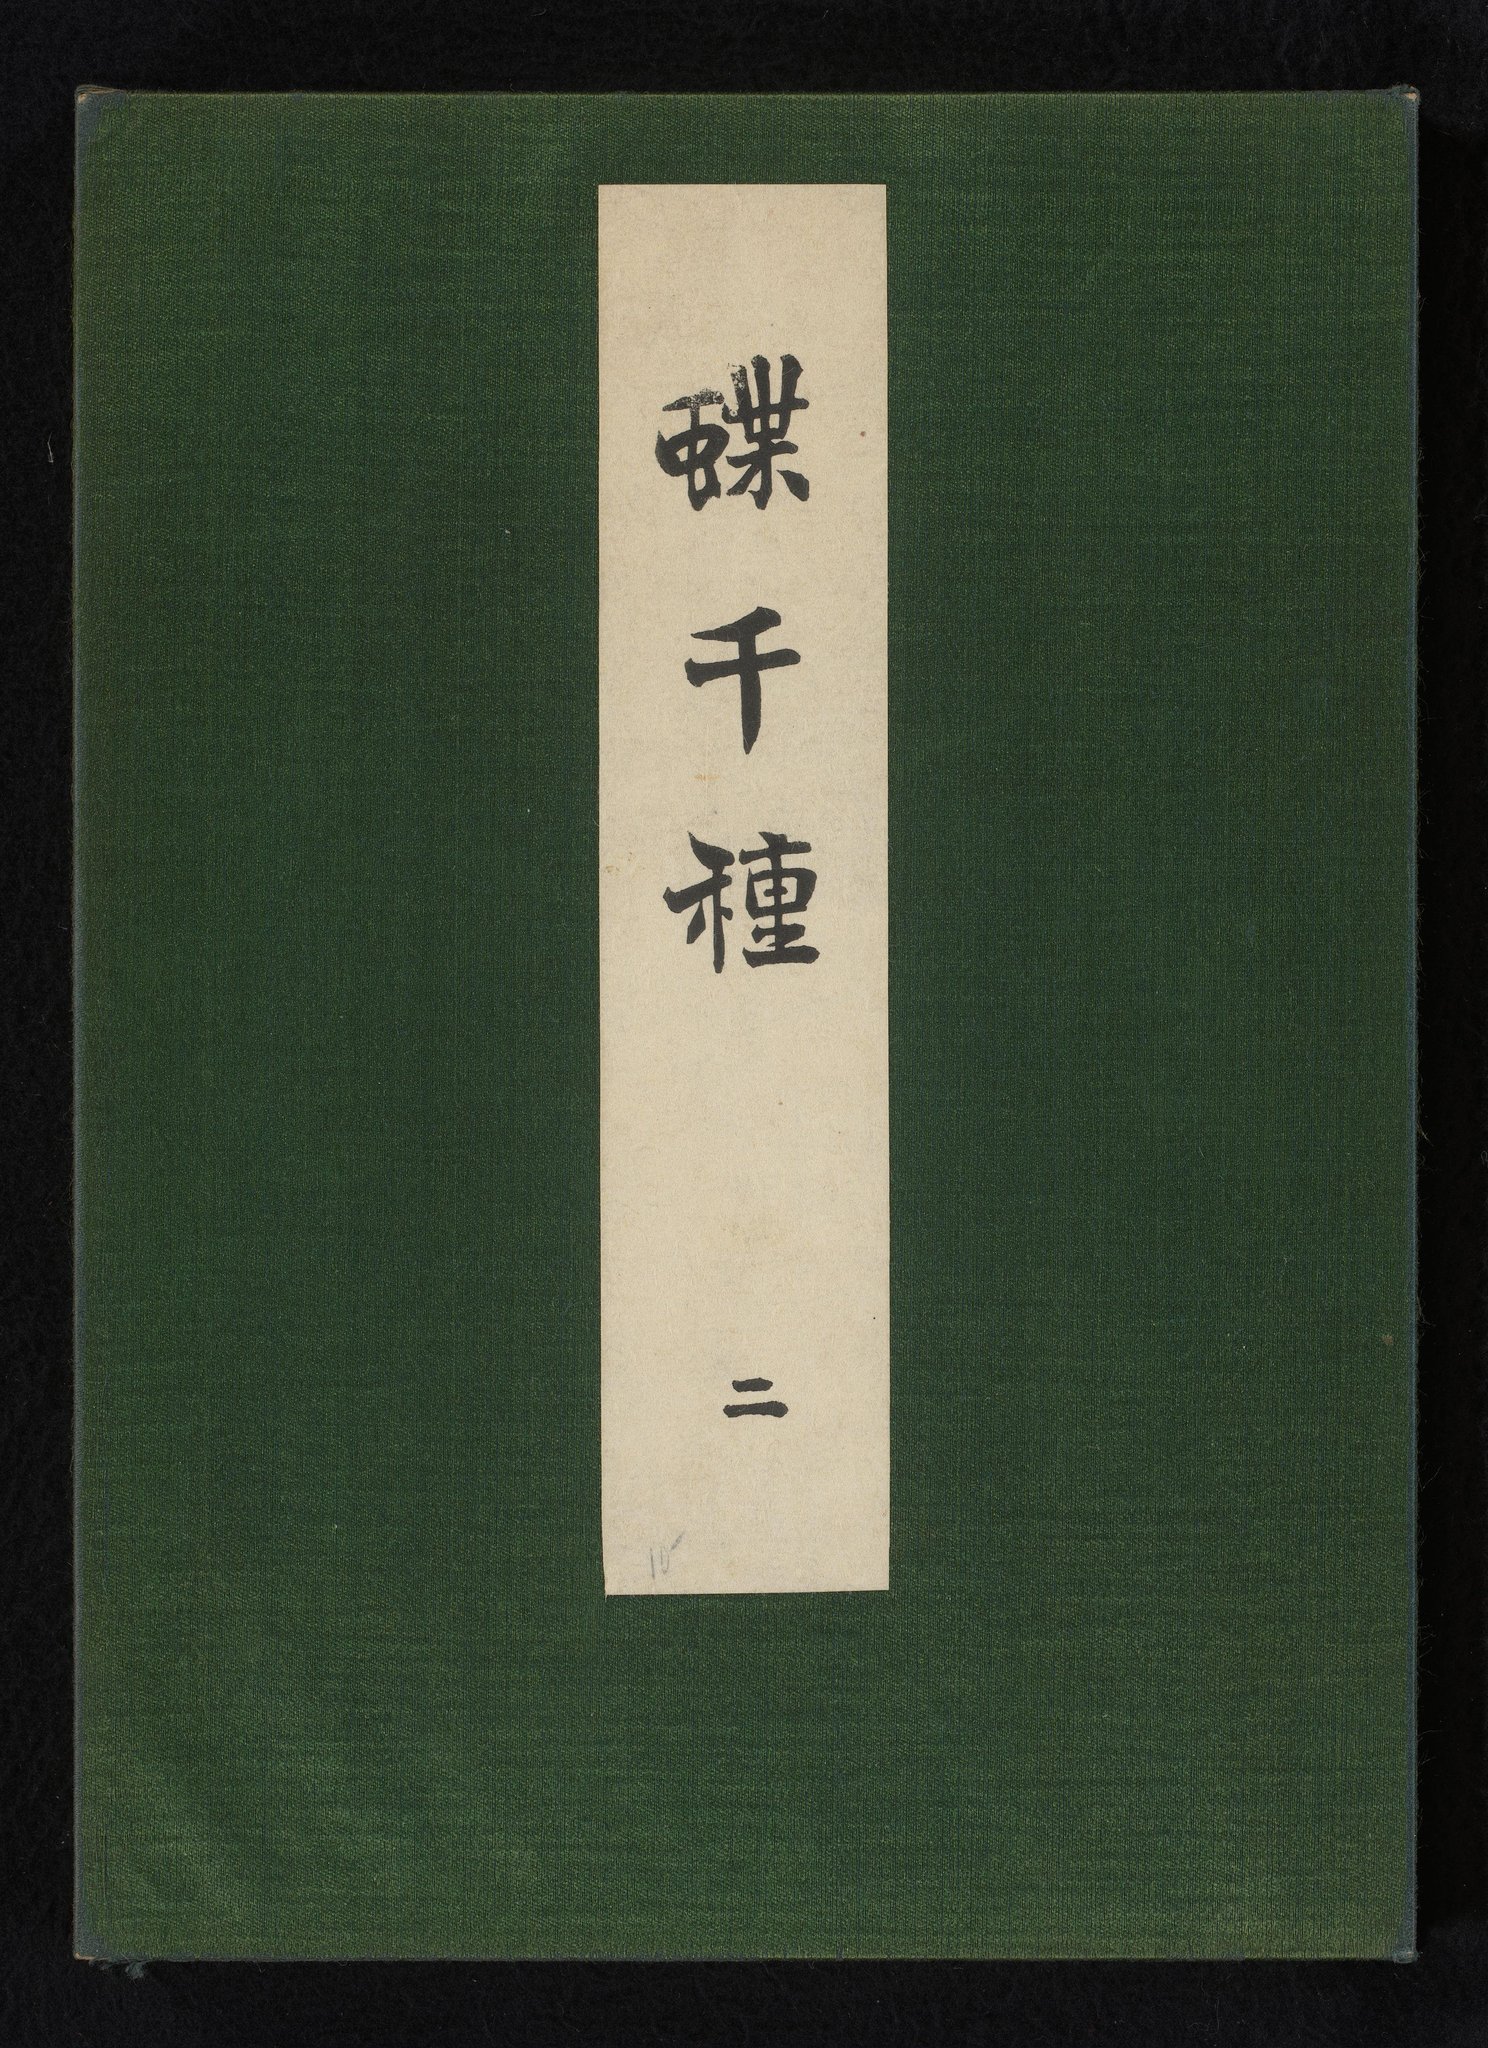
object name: book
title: Een keur van duizend vlinders, deel twee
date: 1908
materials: paper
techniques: woodcut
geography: japan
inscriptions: date